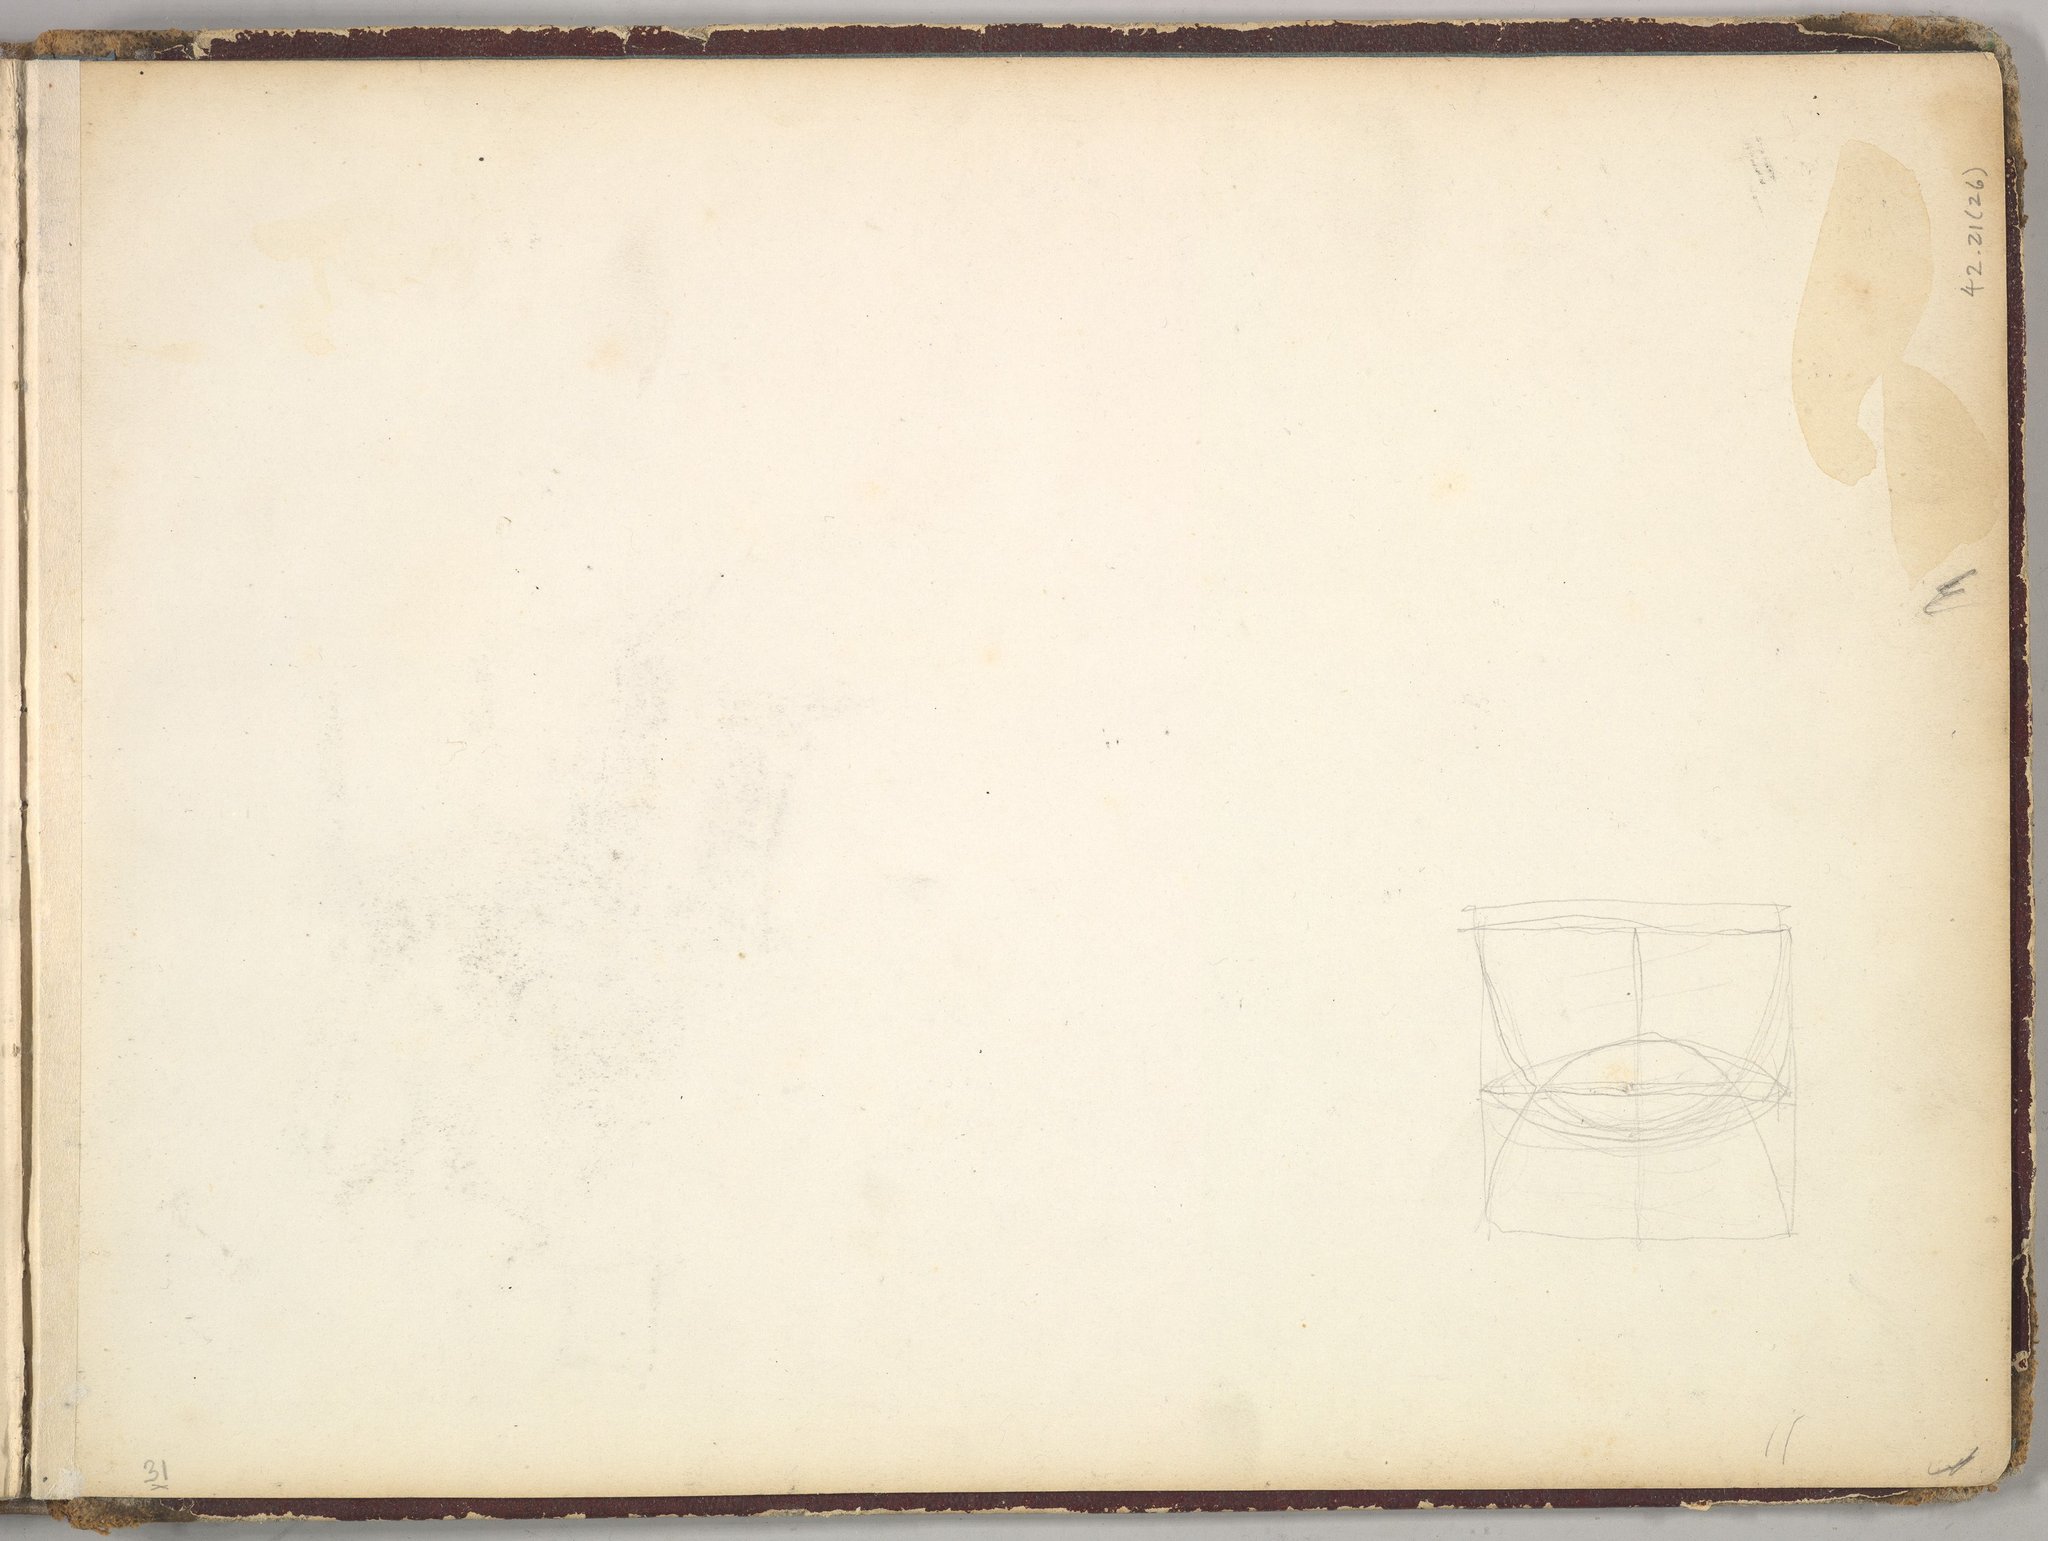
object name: drawing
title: Geometrical Figure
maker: frederic, lord leighton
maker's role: artist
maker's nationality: british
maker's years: 1830-1896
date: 1855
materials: graphite